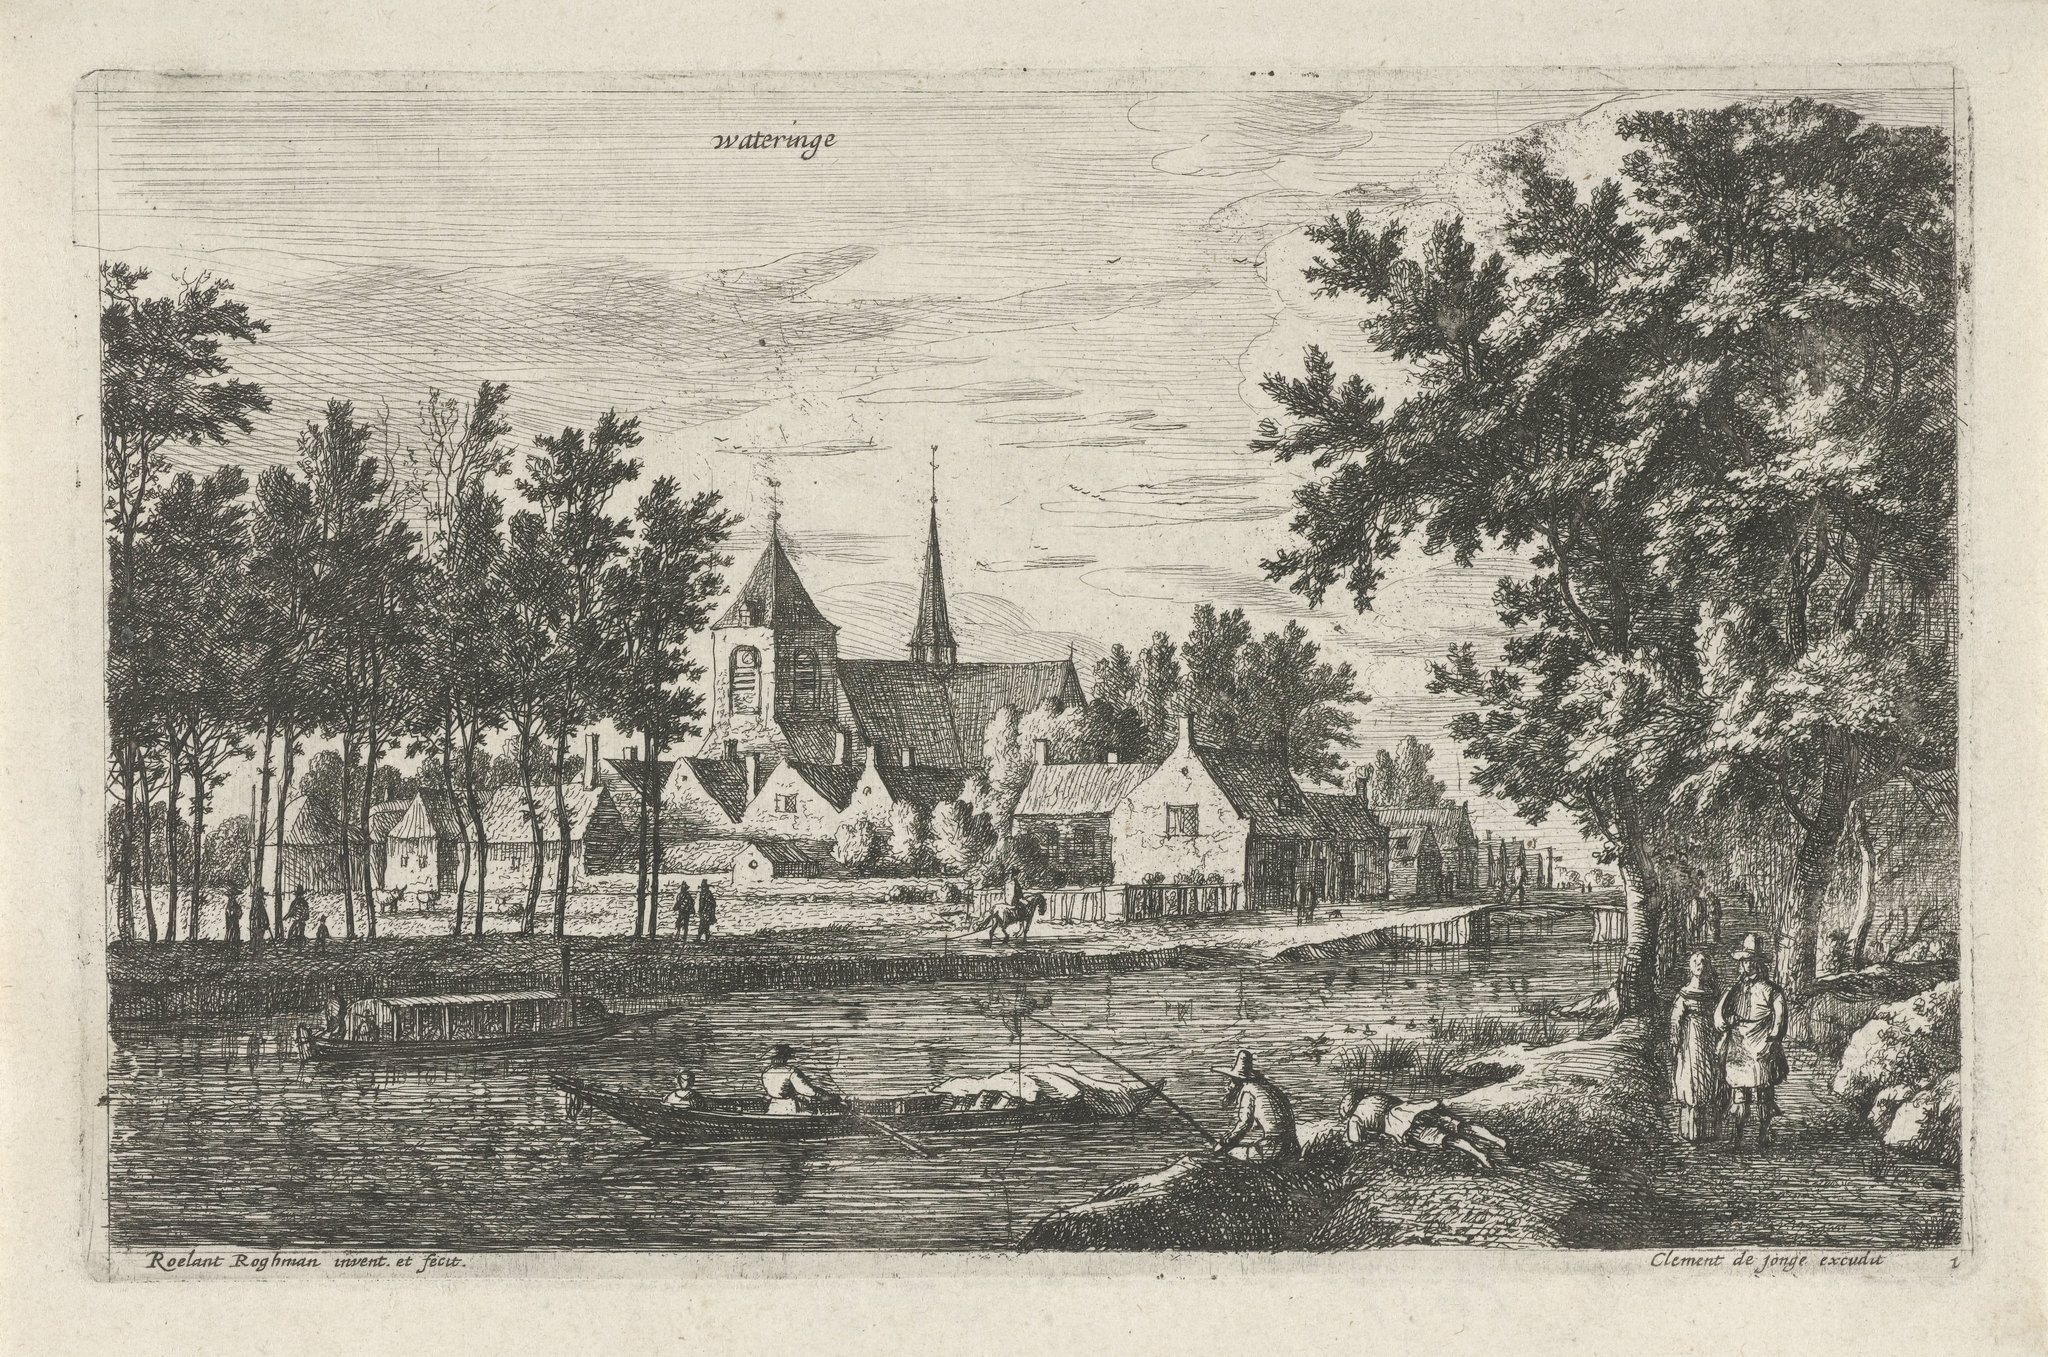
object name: titelprent, frontispice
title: Dorpsgezichten in de Noordelijke Nederlanden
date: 1643-1677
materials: paper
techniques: etching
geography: amsterdam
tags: prospect of village, silhouette of village, river, church (exterior), rowing-boat, canoe, etc., fisherman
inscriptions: collector's mark: Lugt 240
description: Gezicht vanaf het water op het dorp Wateringen en een kerk. Rechts een bospad met enkele passanten en een visser aan de waterkant. Op het water twee boten en op de achtergrond een brug. Rechtsonder genummerd: 1.